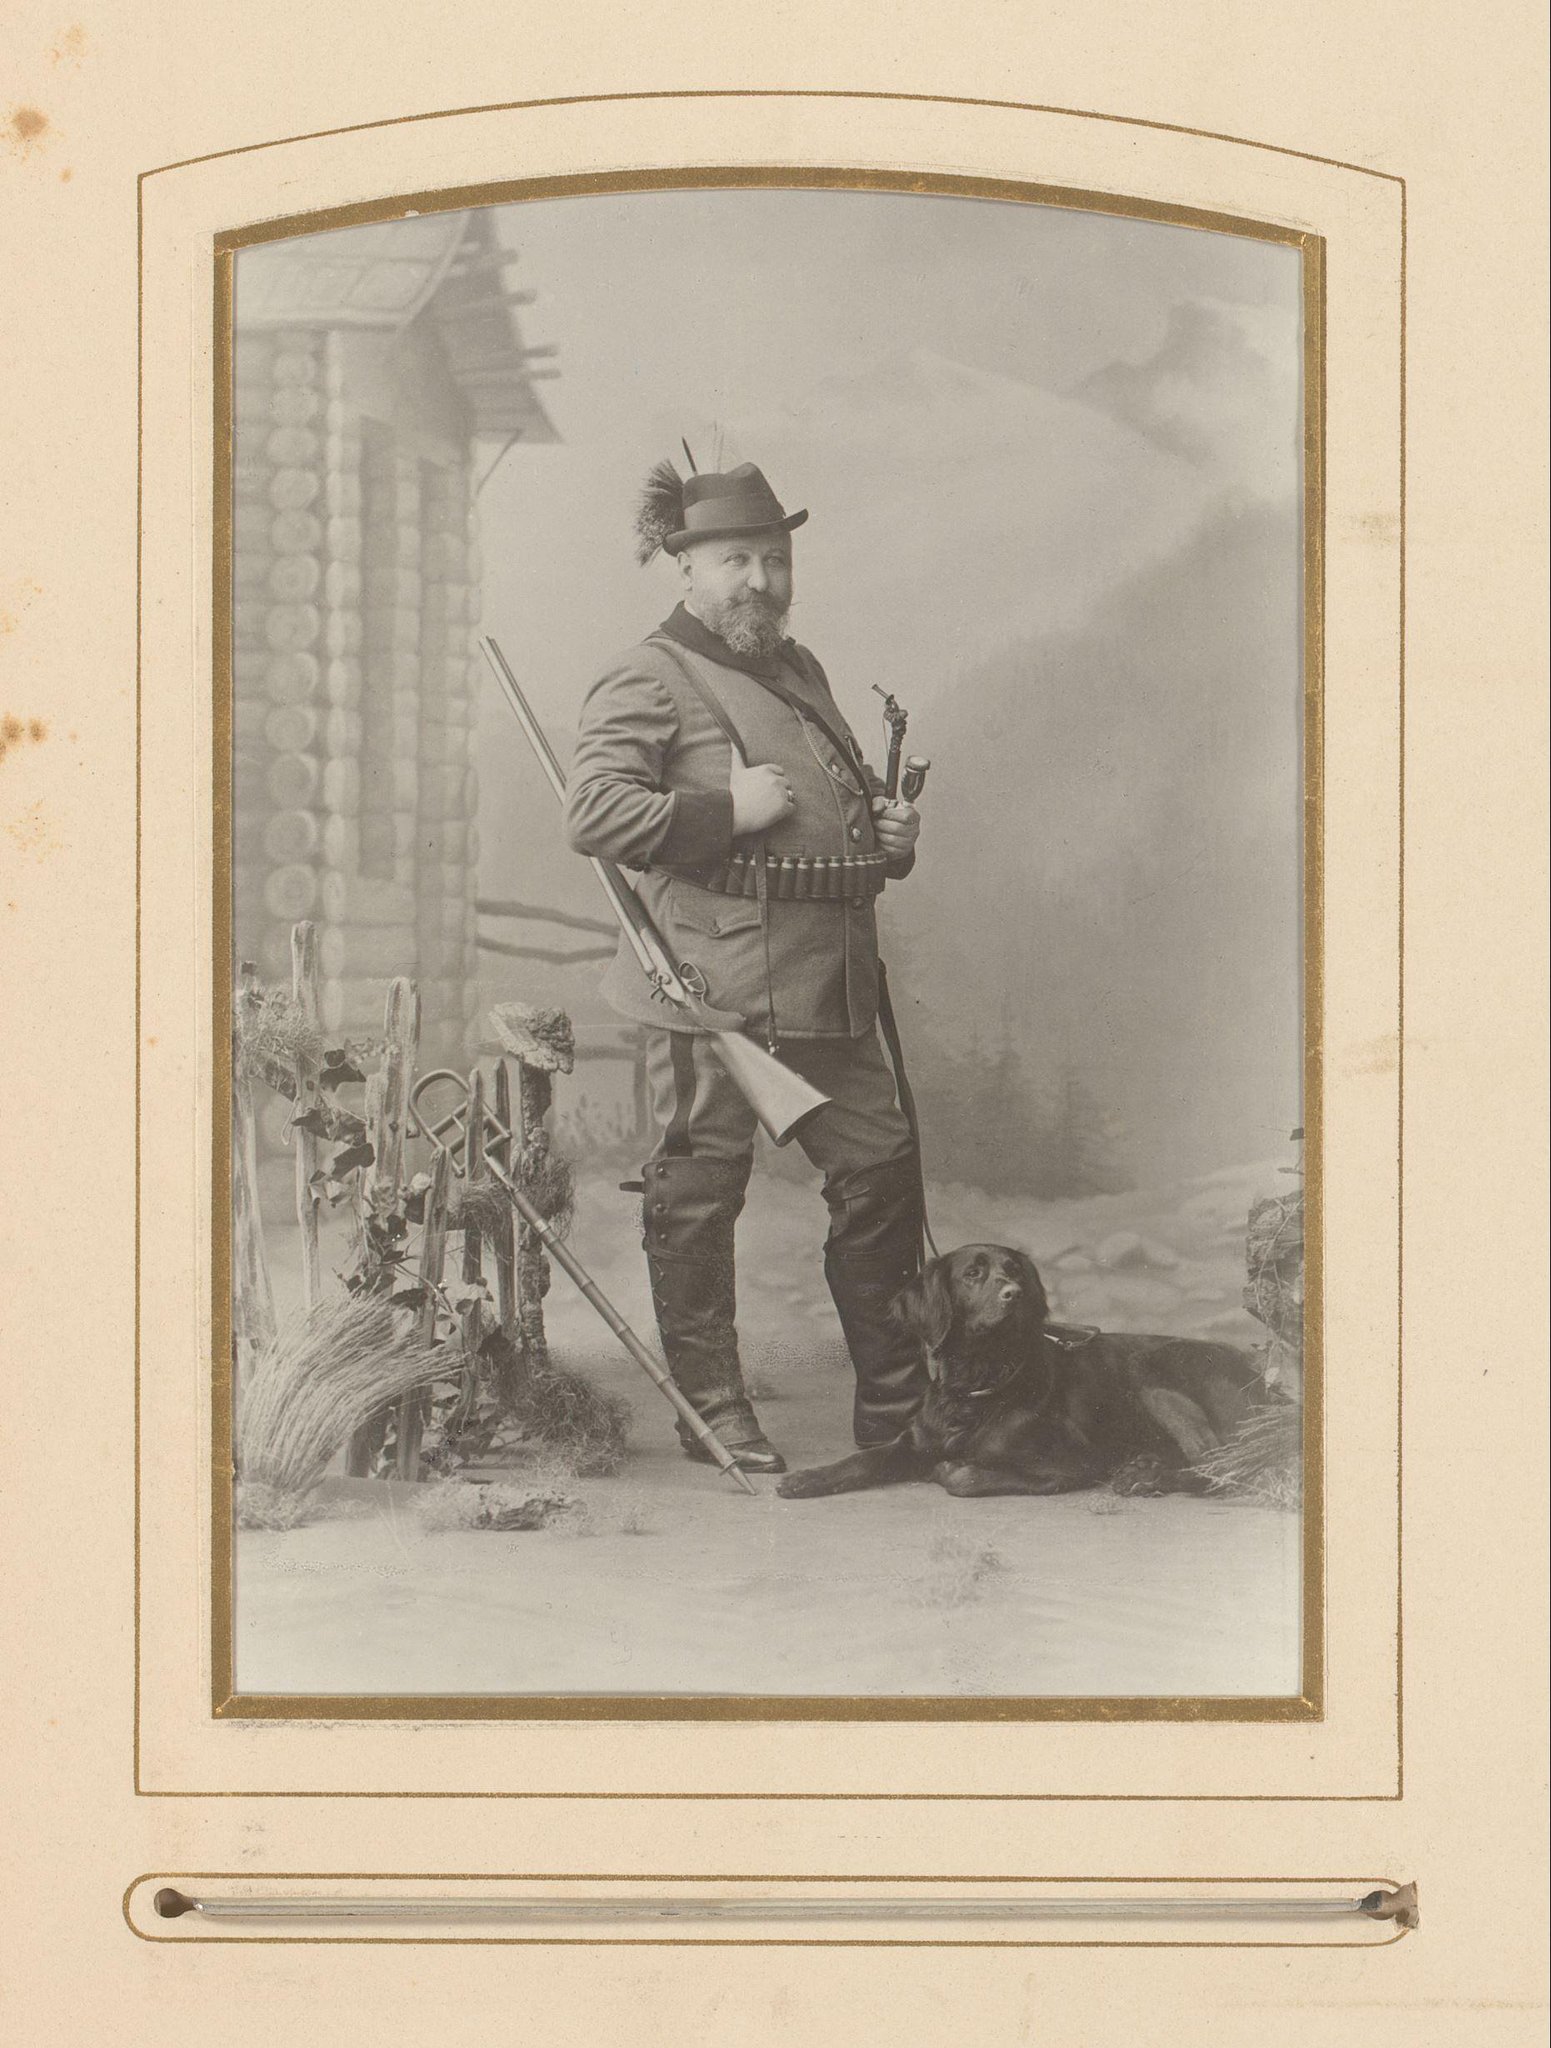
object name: cabinet photograph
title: Portret van een man in uniform met jachtgeweer en een hond aan zijn voeten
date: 1895-1920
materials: cardboard, photographic support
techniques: matte daylight collodion silver print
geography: stuttgart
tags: historical persons, firearms: rifle, (military) uniforms, dog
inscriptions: inscription: ‘Stober&Co/ Stuttgart/ Gymnasiums-Str. 6./ TELEPHON No 1467./ No. 19403/ PLATTE RESERVIRT.’